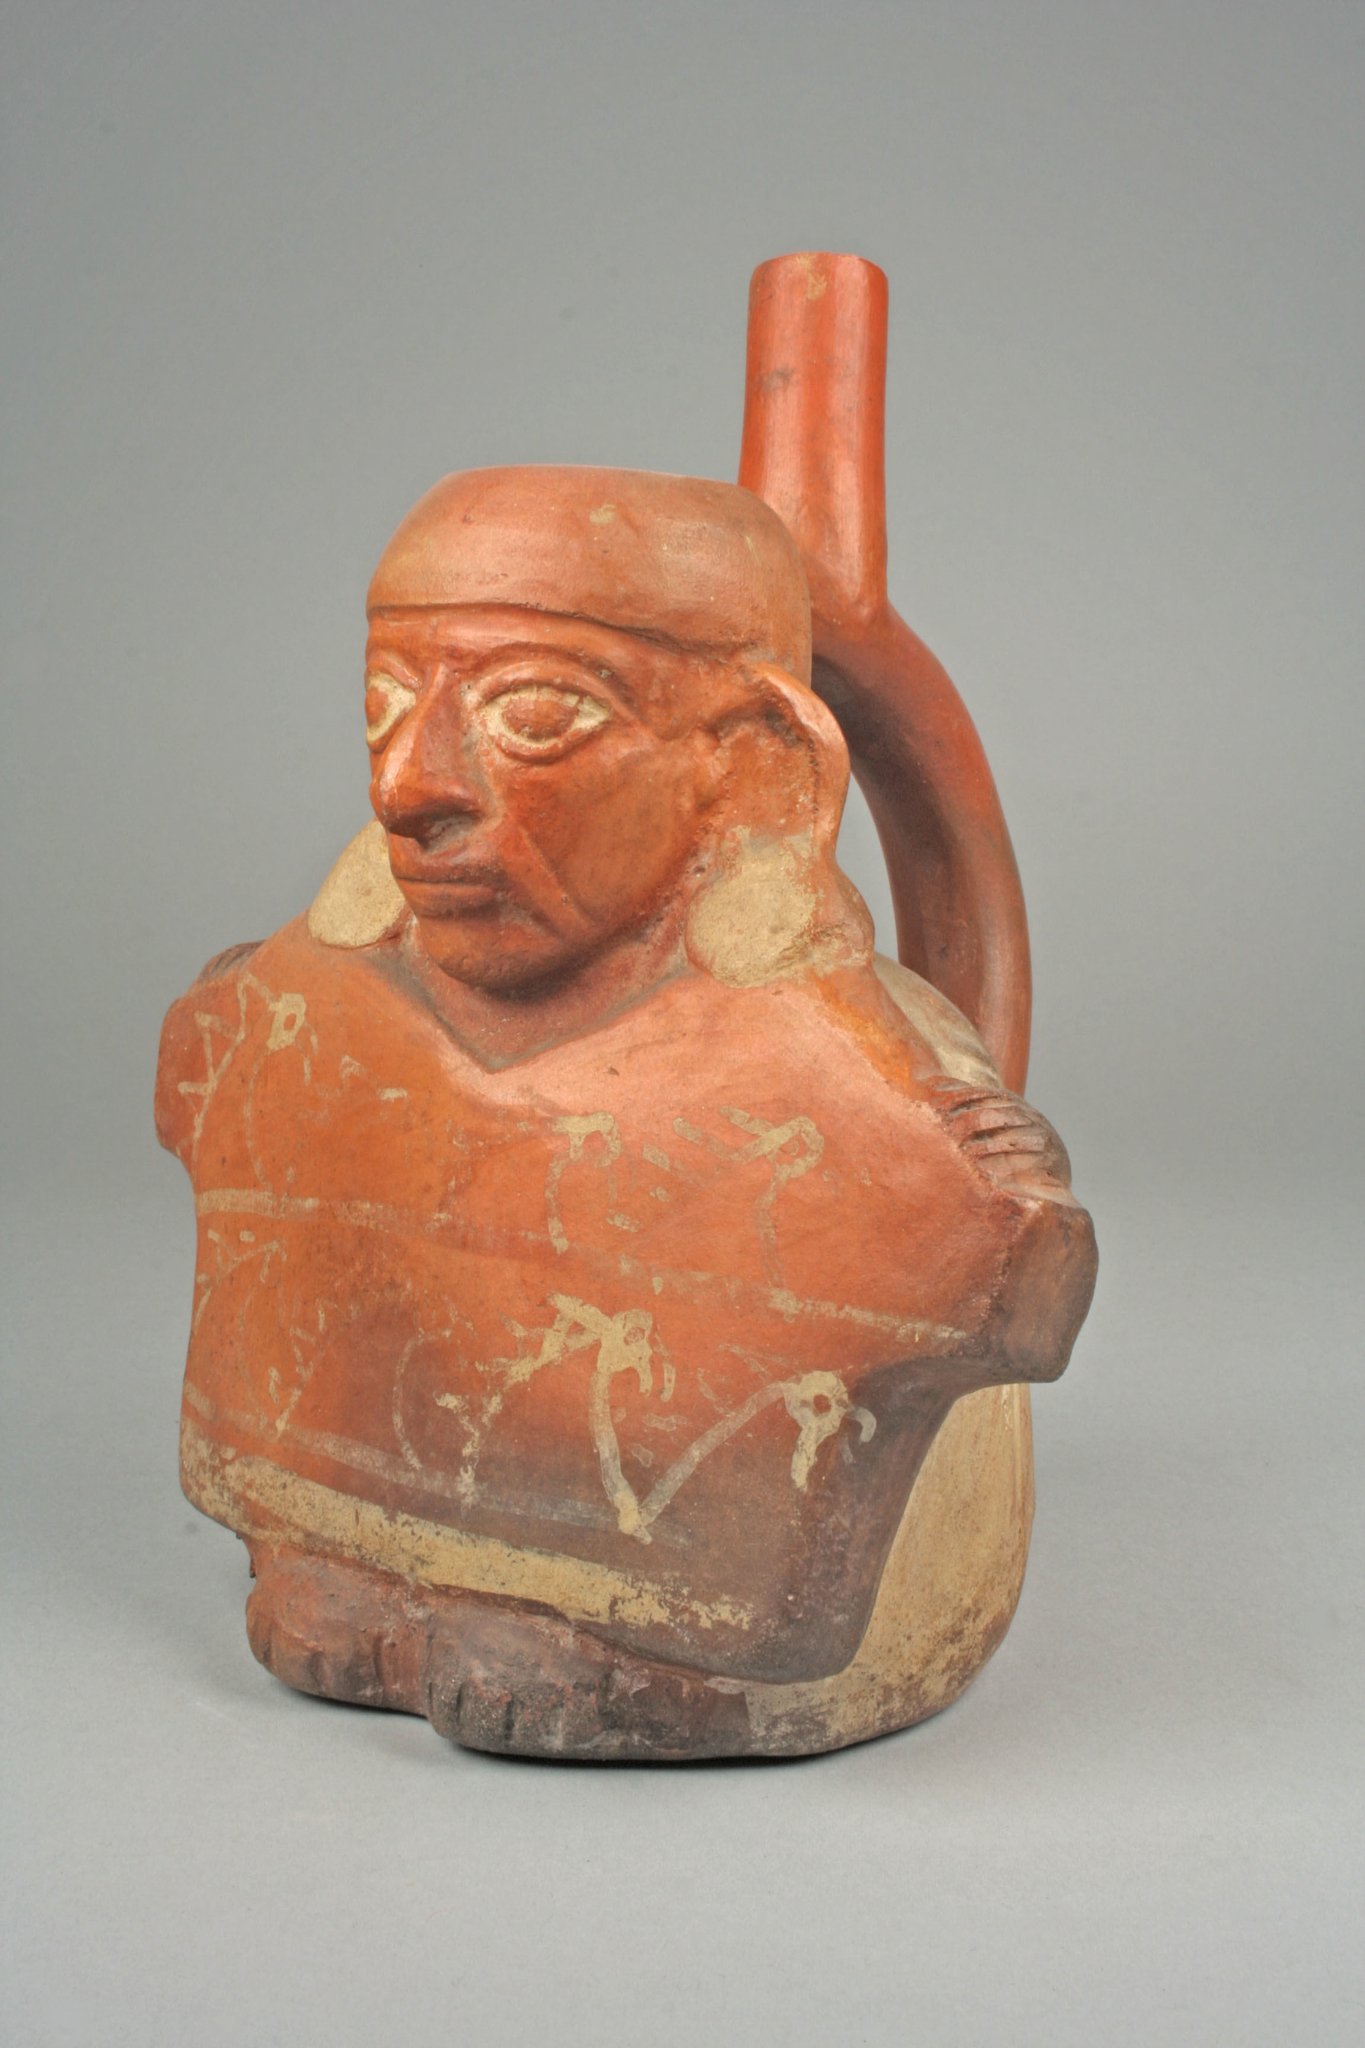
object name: bottle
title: Bottle, Figure Showing Tunic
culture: moche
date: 1-300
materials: ceramic, pigment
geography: peru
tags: human figures